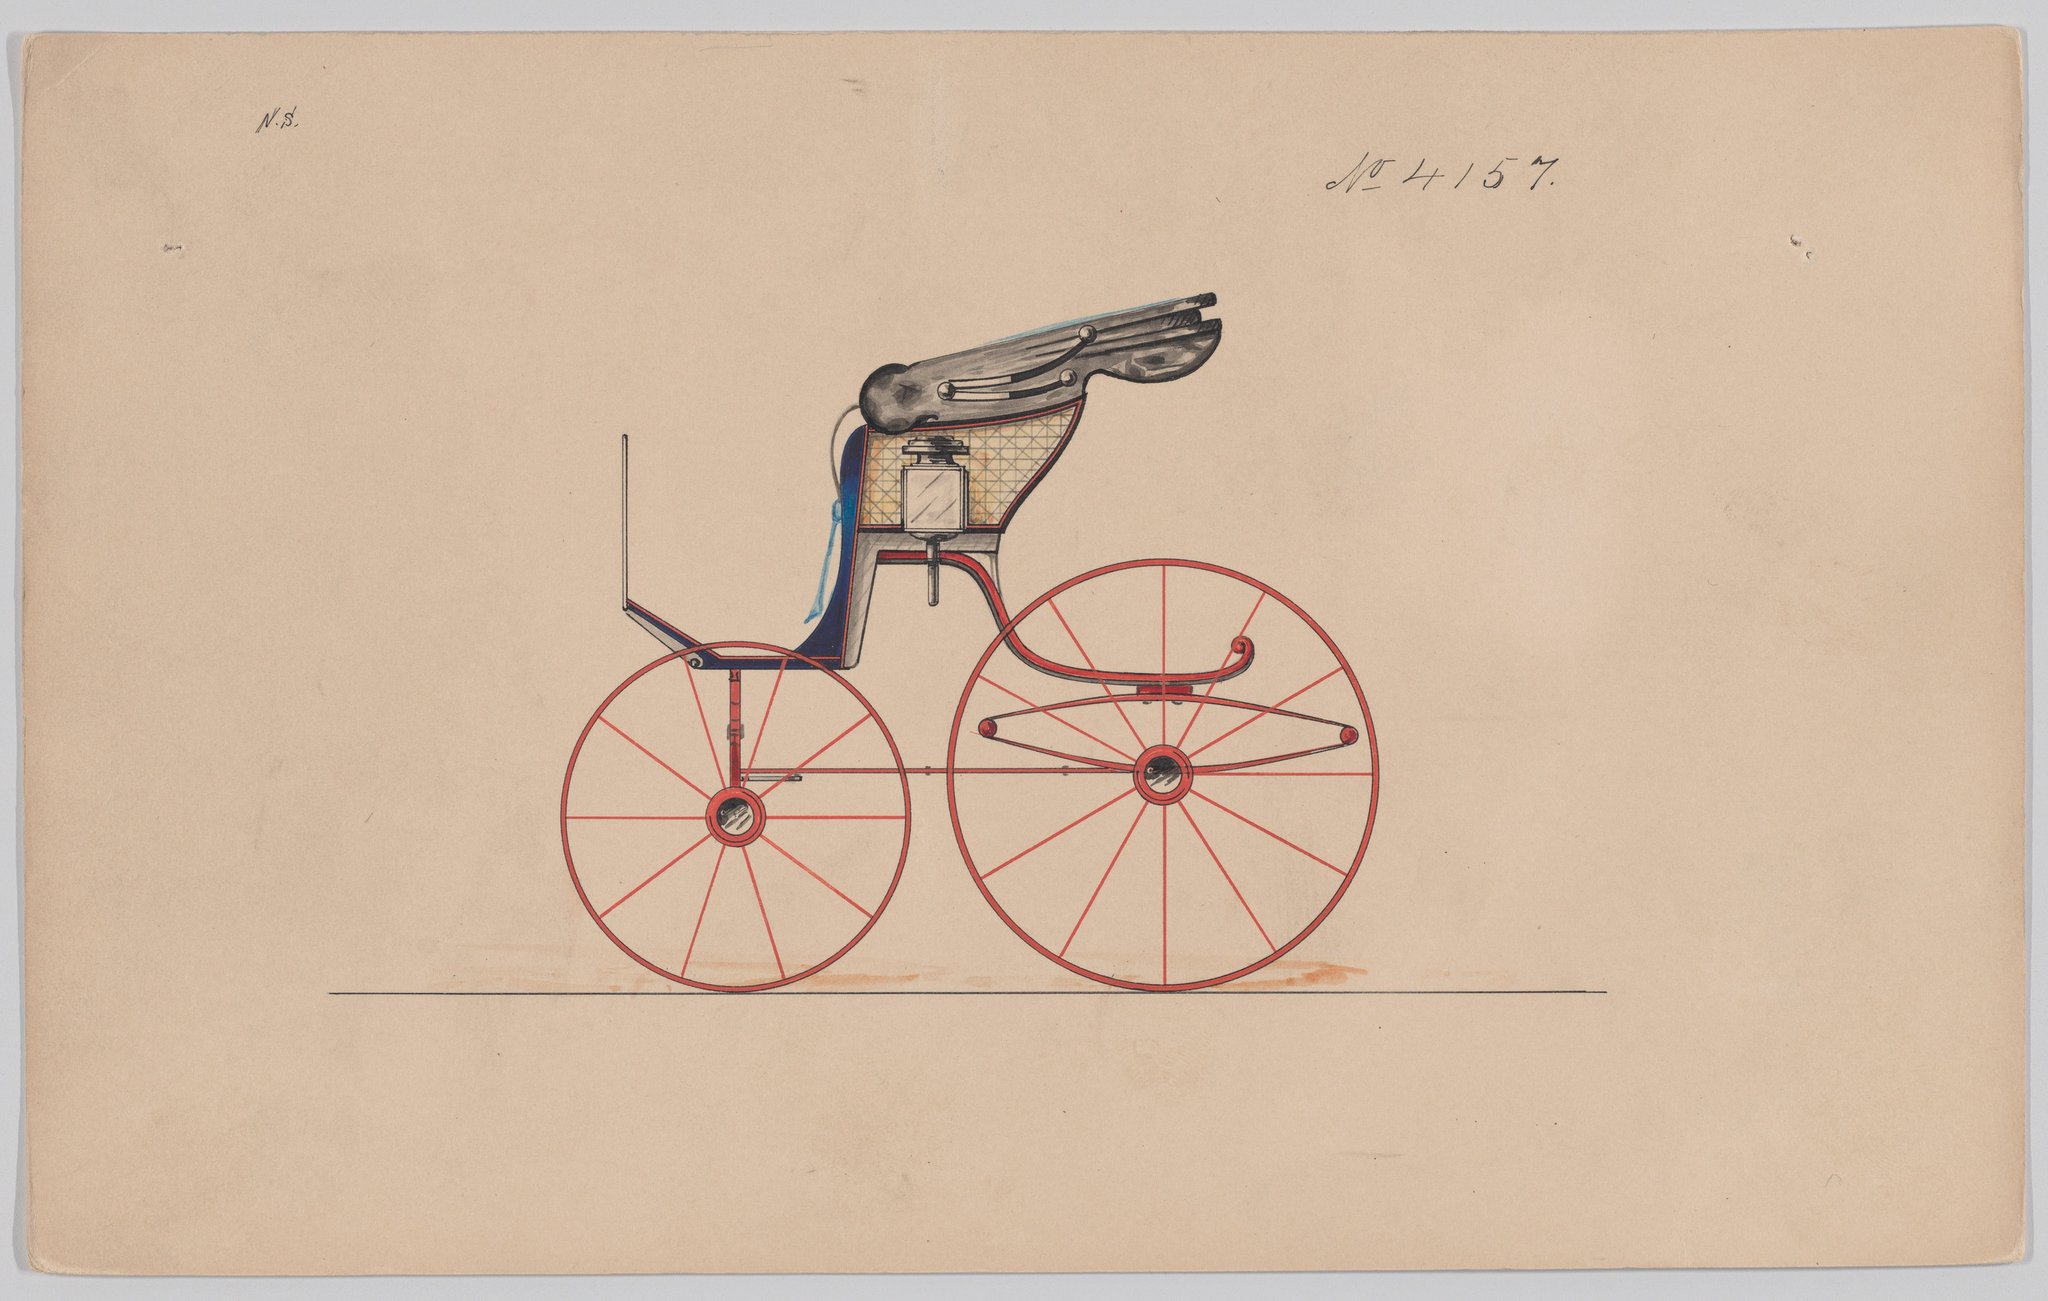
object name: drawing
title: Design for Pony Phaeton, no. 4157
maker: brewster & co.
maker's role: manufacturer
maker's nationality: american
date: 1892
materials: gouache, ink, watercolor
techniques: pen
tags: carriages